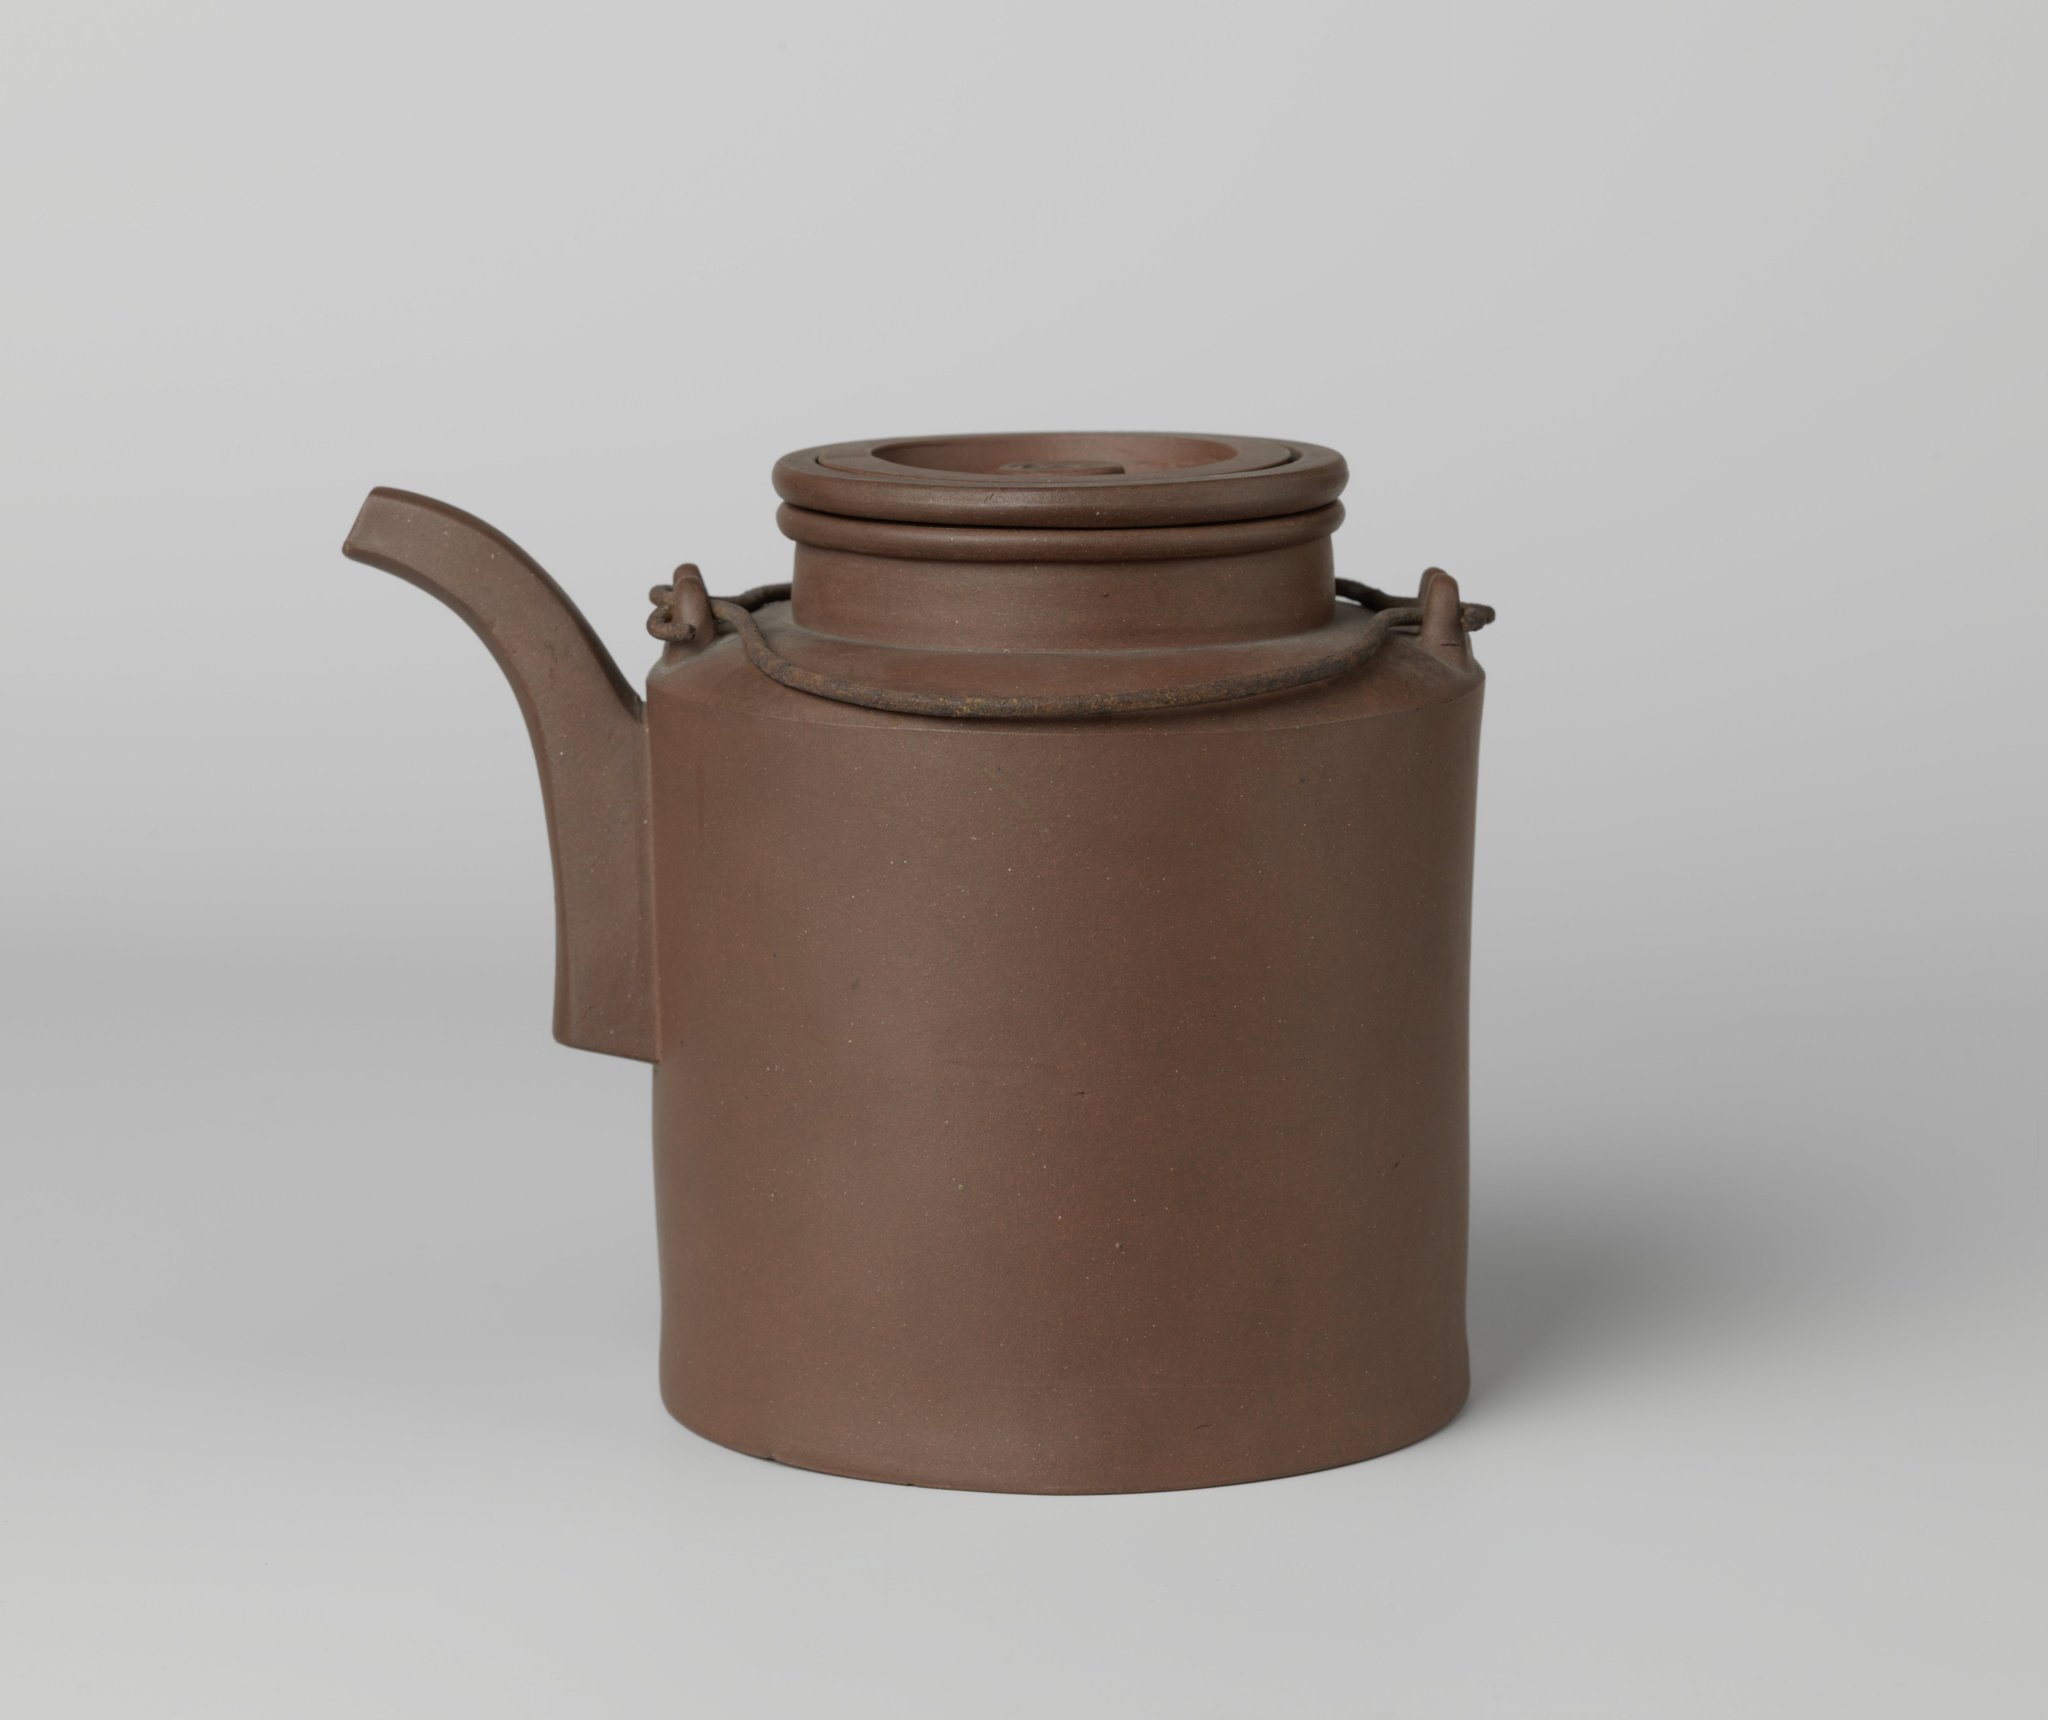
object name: lid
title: Teapot of red stoneware with filter and wire handles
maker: Anonymous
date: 1800-1899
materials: iron, stoneware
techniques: forming, turning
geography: china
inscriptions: mark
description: This teapot has a round body and a square spout, and handles of iron. Inside the pot is a perforated stoneware infuser for the tea leaves. The pot’s shape deviates from traditional designs. For instance, the cover is hollow rather than convex, and the bottom is completely flat. It is possible that the teapot was inspired by objects made of metal.